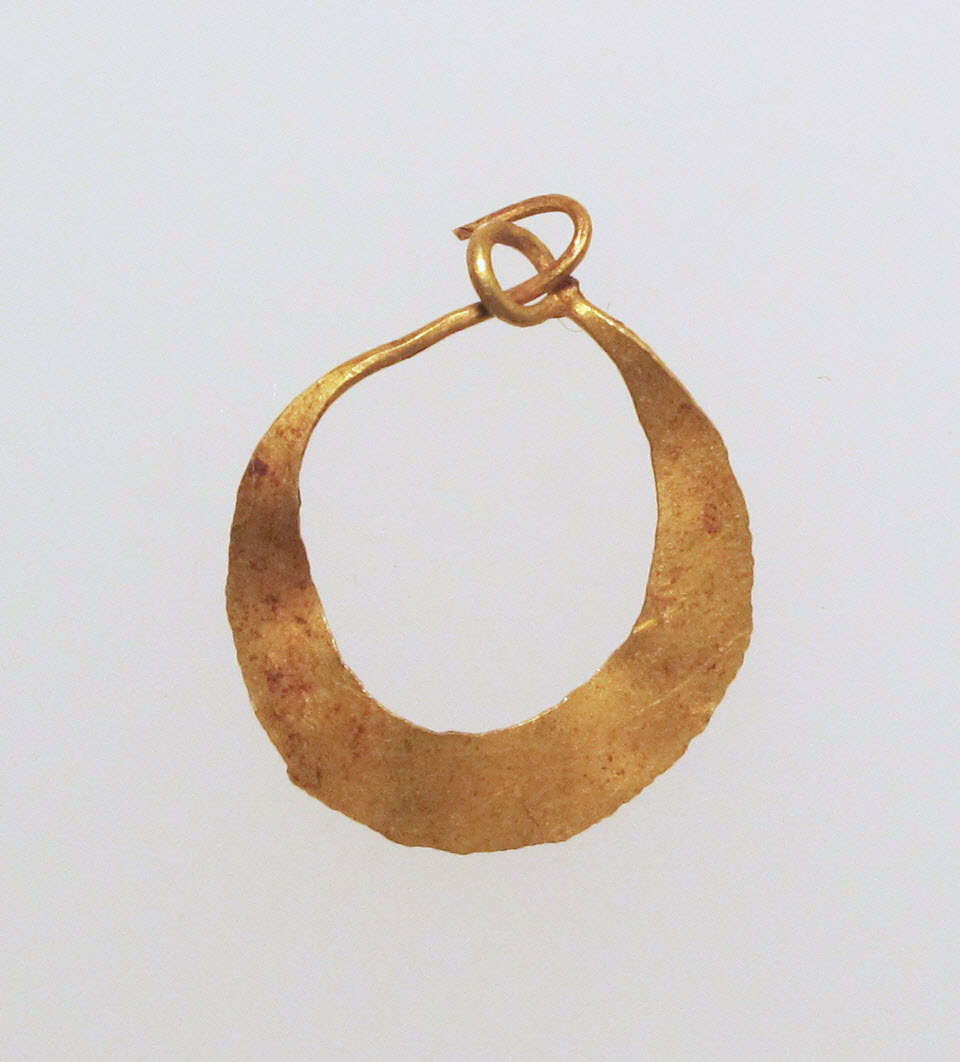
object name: earring, crescent shaped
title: Earring, crescent-shaped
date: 7000 BCE-330 CE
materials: gold